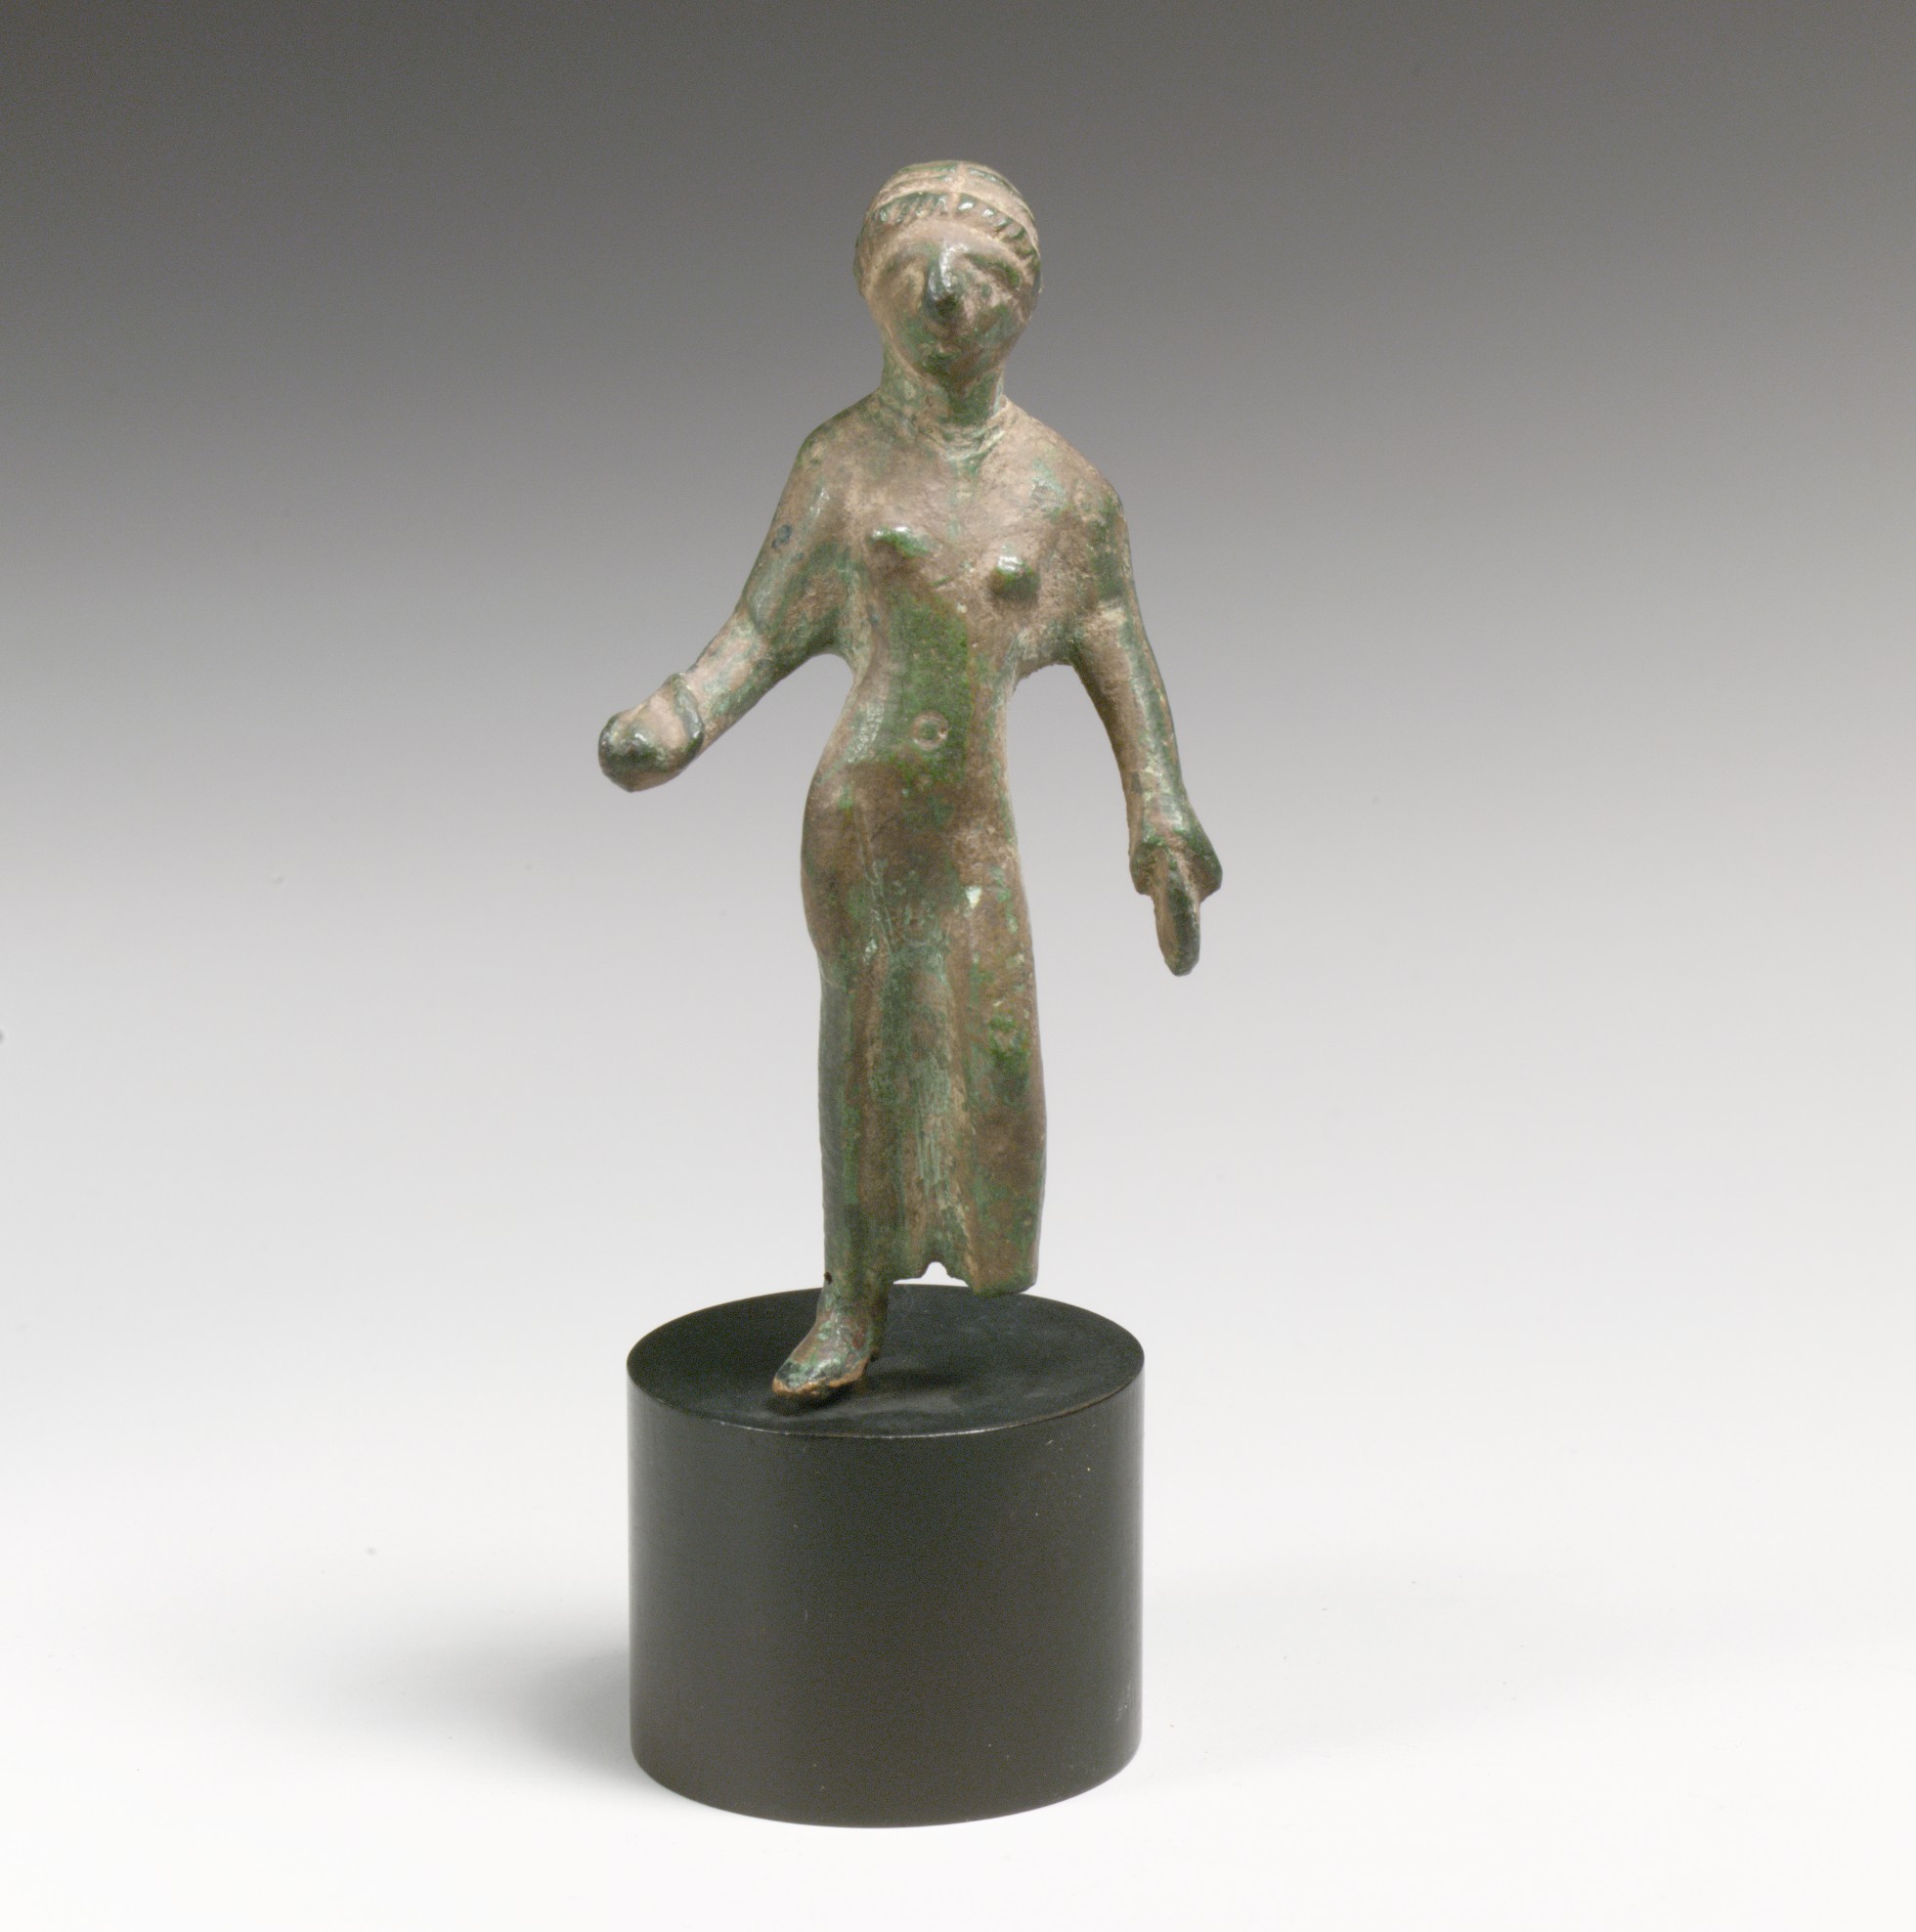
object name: statuette of a woman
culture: italic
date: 434-466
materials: bronze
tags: women